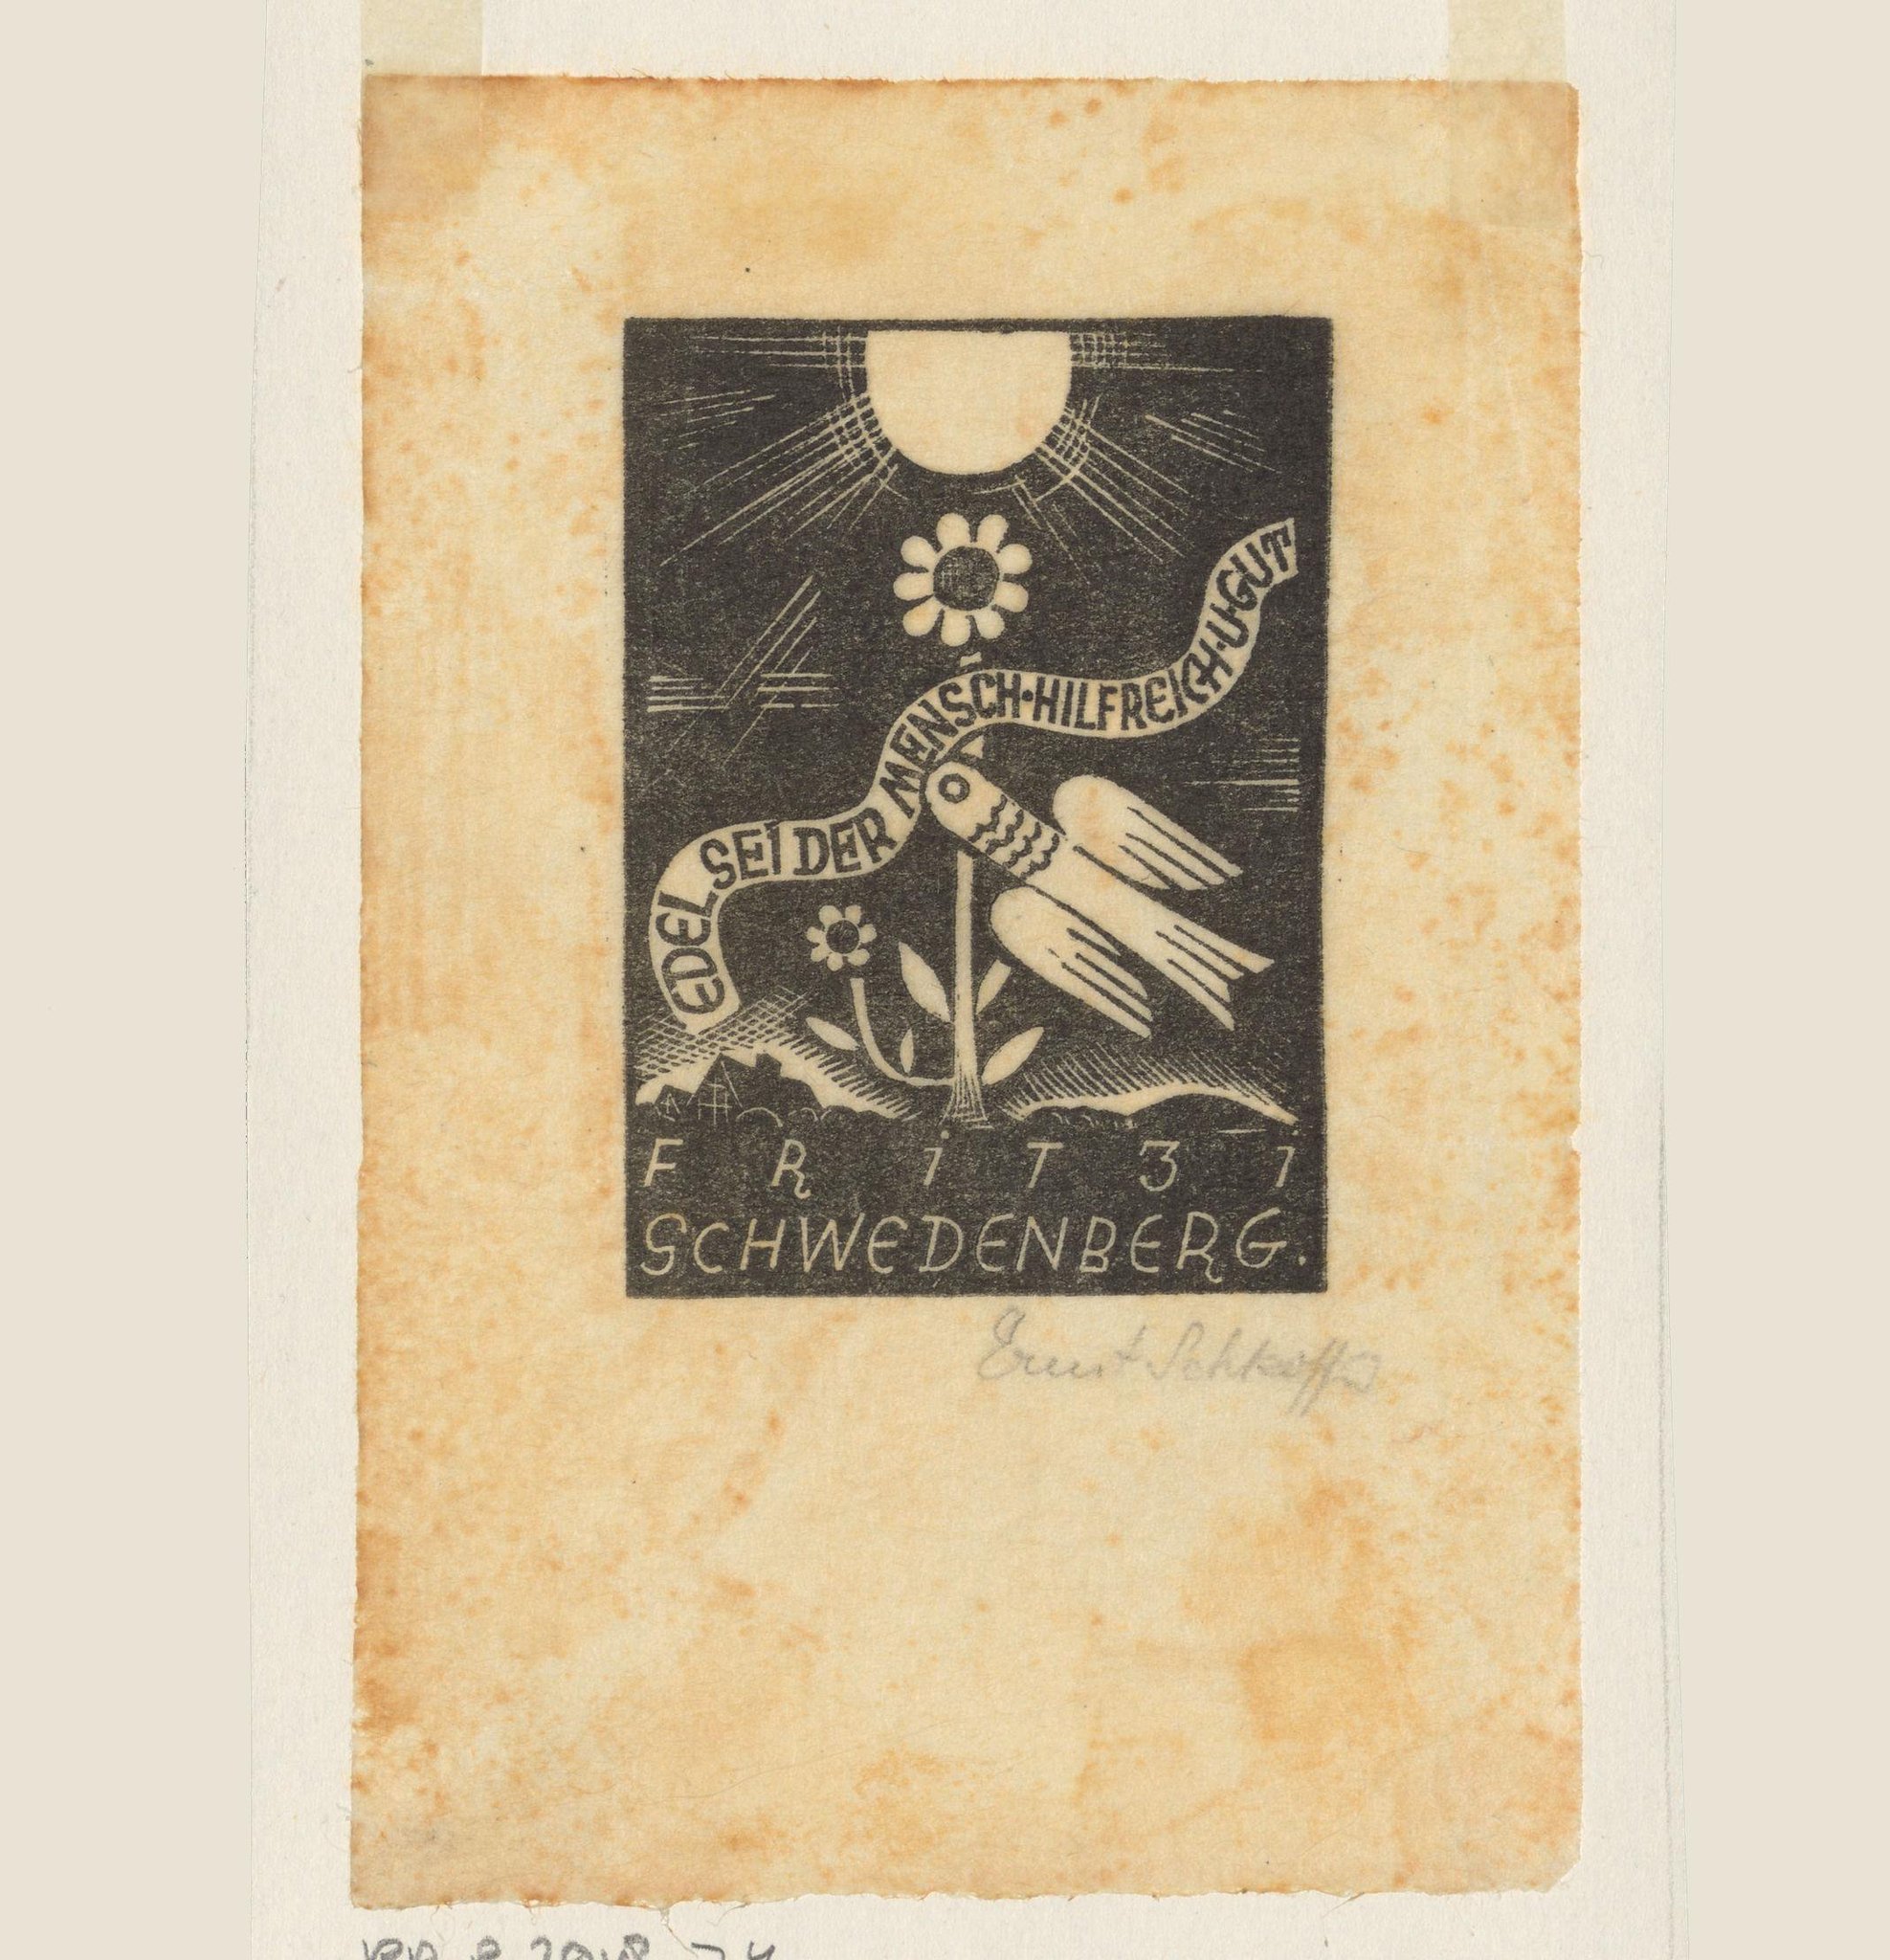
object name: bookplate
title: Ex libris van Fritzi Schwedenberg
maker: Anonymous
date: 1900-1949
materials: paper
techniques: woodcut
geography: germany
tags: flowers, birds, sun as celestial body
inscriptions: signature: ‘Ernst Sch[...]’